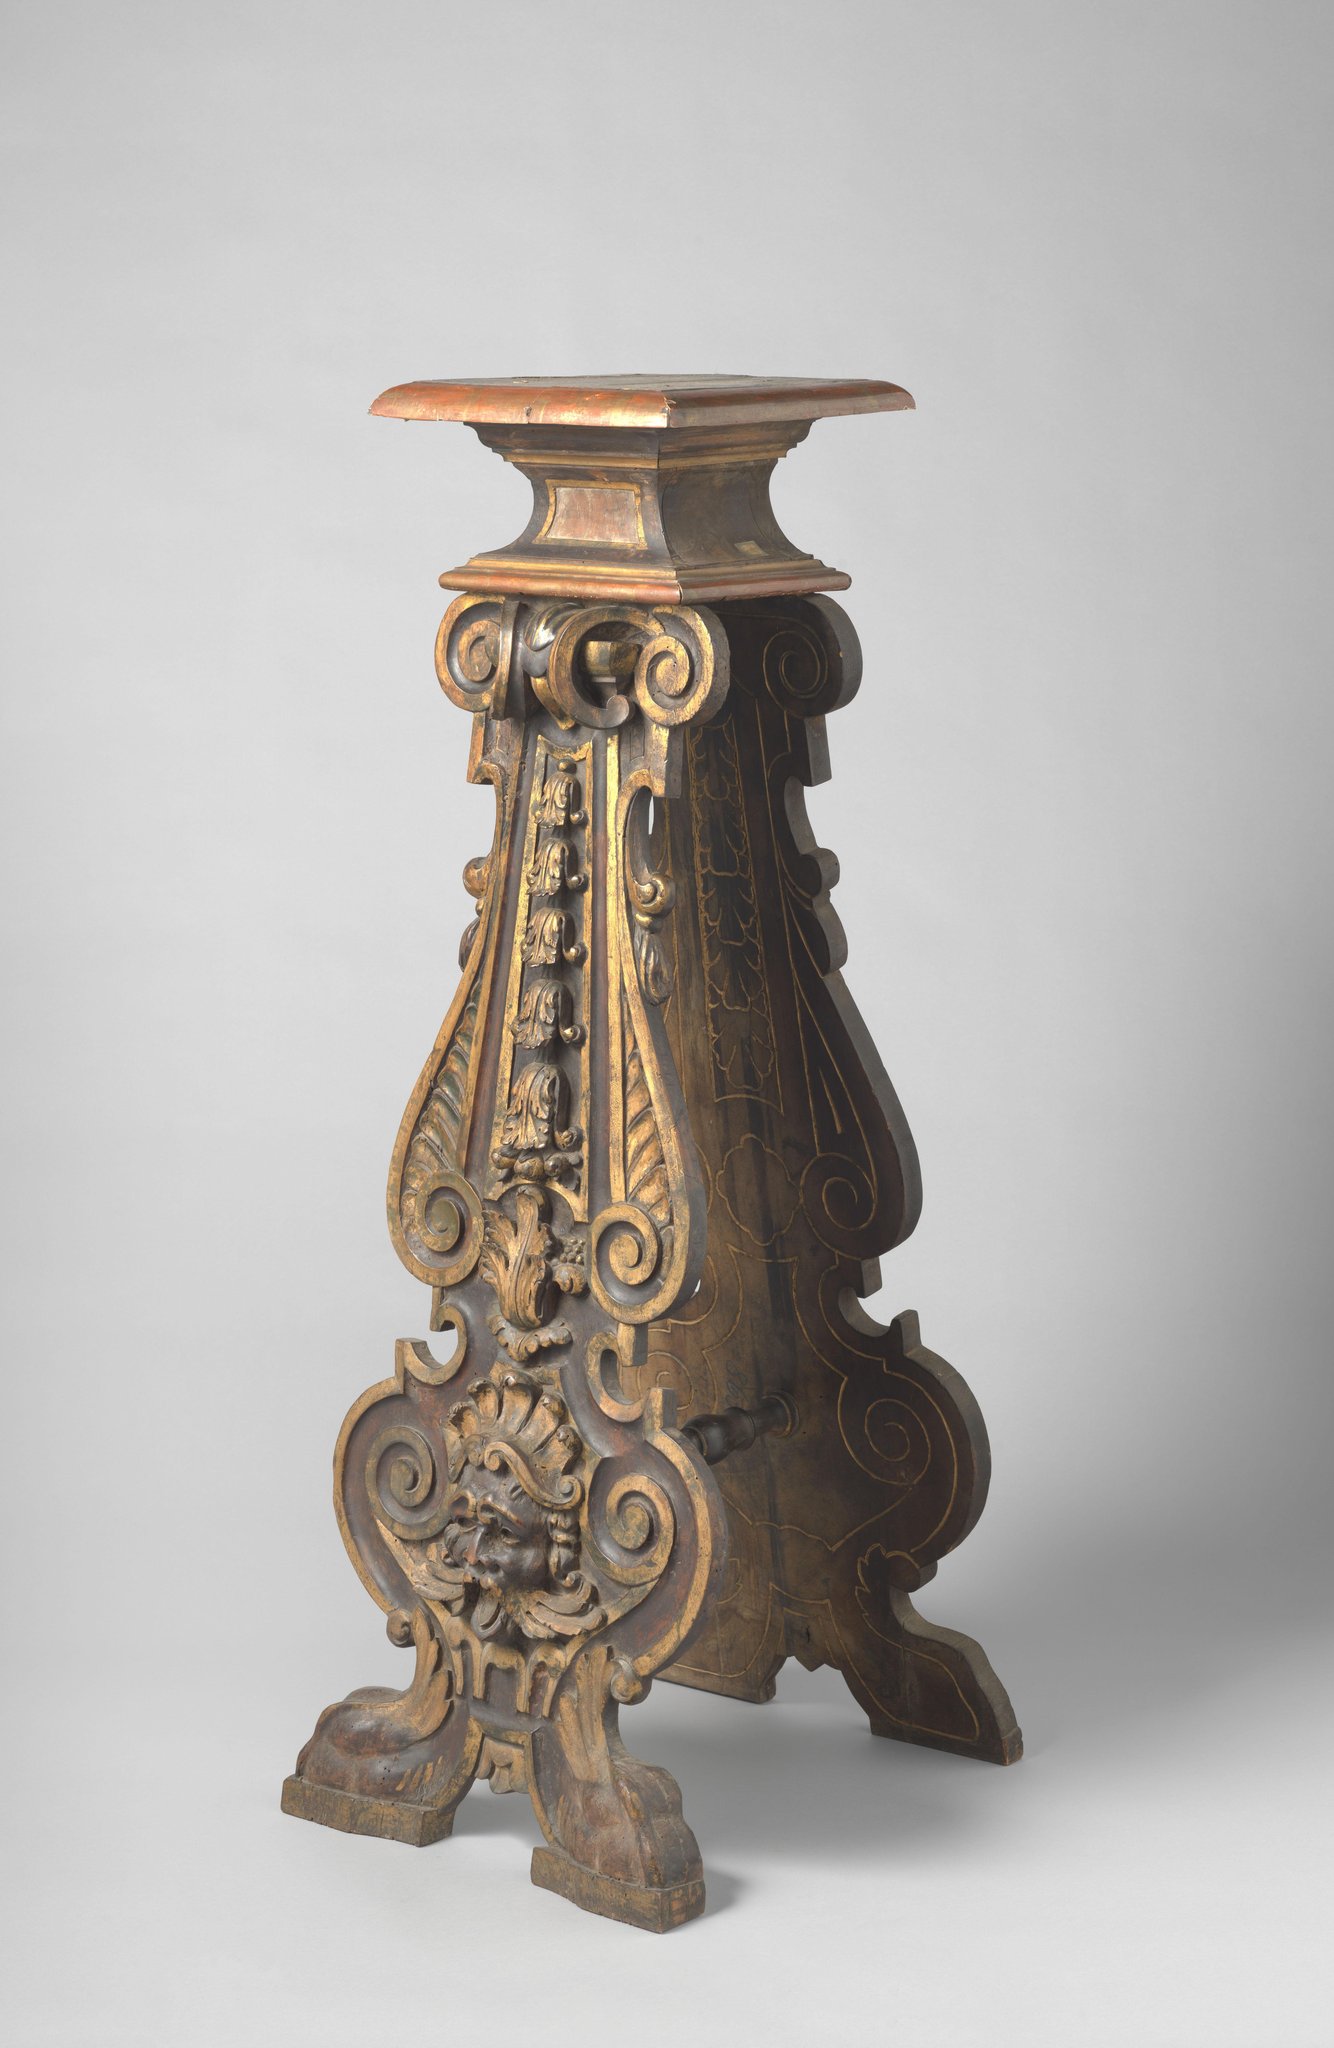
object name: base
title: Voetstuk van gedeeltelijk verguld notenhout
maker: Anonymous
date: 1550-1600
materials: wood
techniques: gilding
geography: italy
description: Voetstuk van gedeeltelijk verguld notenhout. Het platte uitgezaagde voor- en achterpand zijn in gespreide stand geplaatst en worden onderaan door een gelede sport verbonden. De voorzijde toont een gestoken mascaron temidden van in leeuwenklauwen eindigende voluten; erboven een klokjessnoer, eveneens temidden van voluten. Het achterpand heeft aan de binnenzijde een soortgelijke versiering, aangegeven door verdiepte vergulde contouren. Het voetstuk is ingesnoerd en geprofileerd. Zie: BK-16869-b.